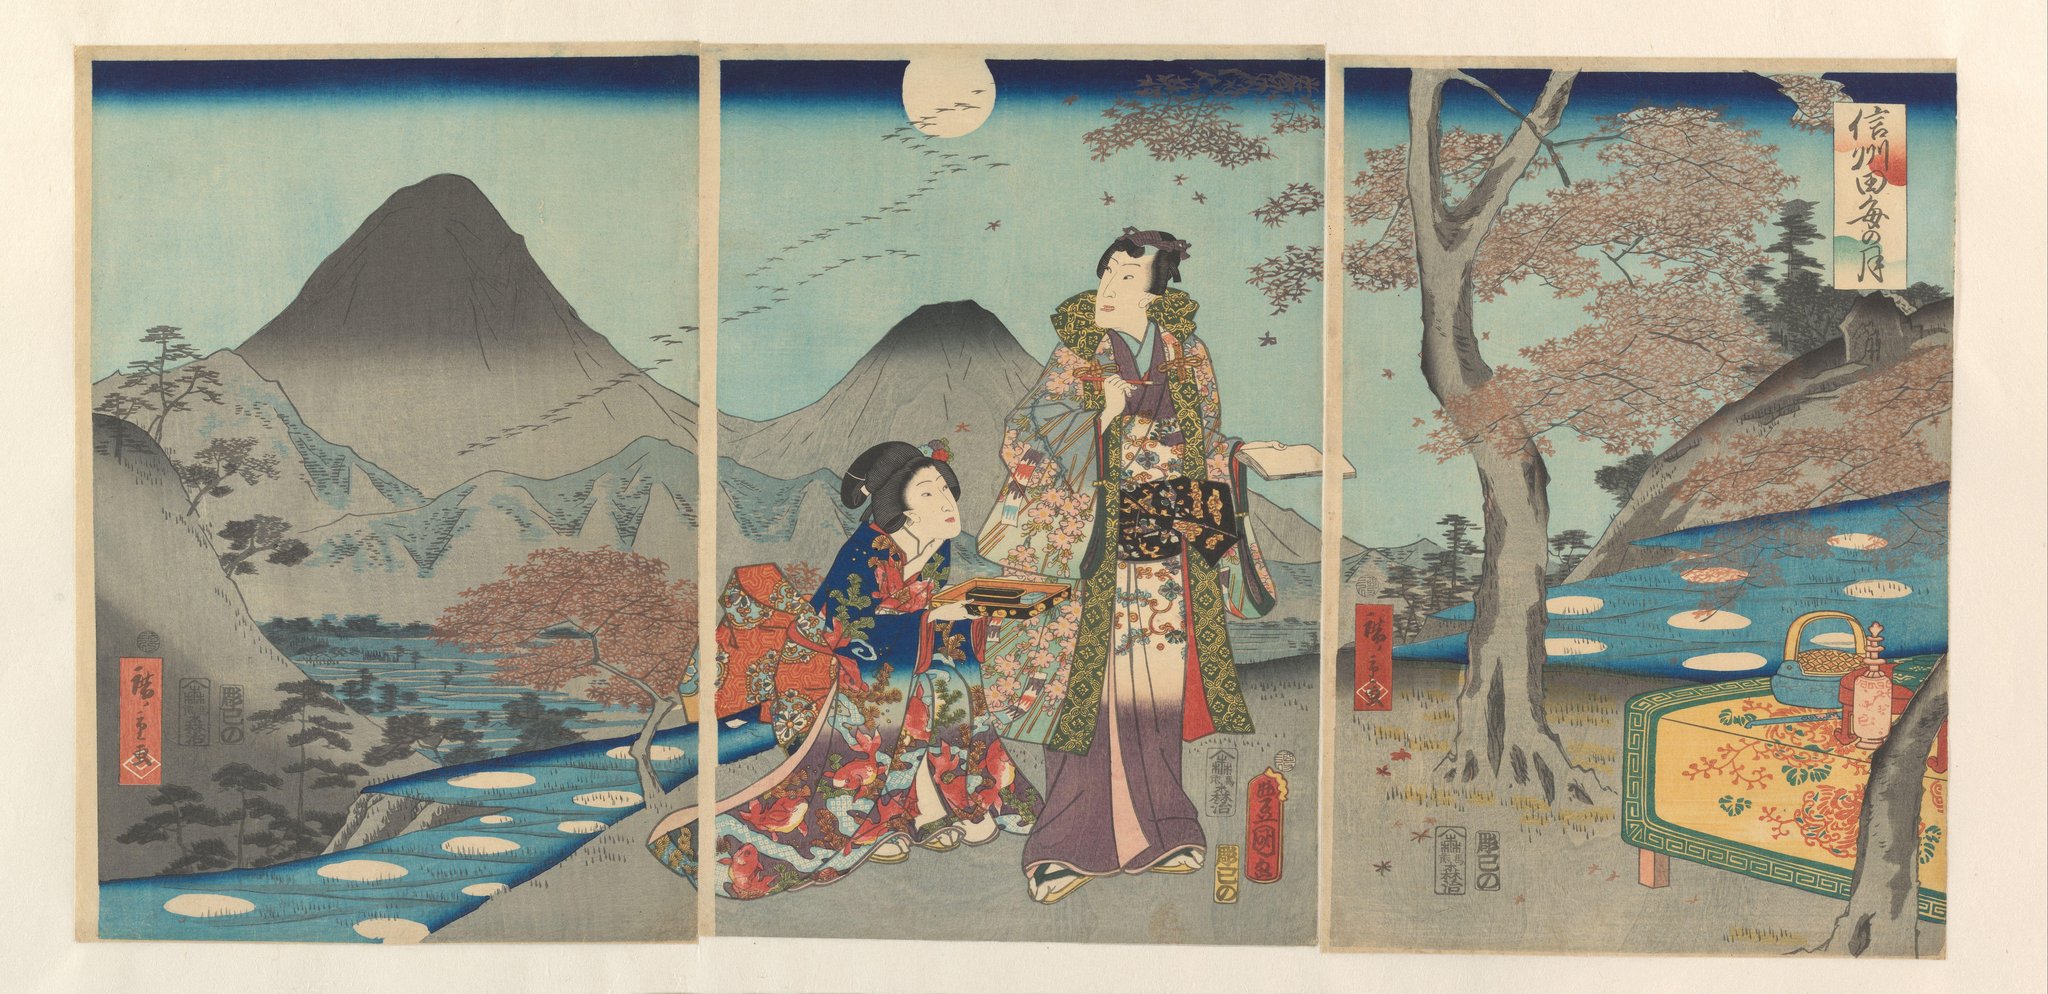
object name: print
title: De maan gereflecteerd in de rijstvelden van Shinano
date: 1861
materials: paper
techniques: woodcut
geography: japan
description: Prins Genji en een dame, terwijl de volle maan in de rijstvelden weerspiegelt. Deel van een triptiek.